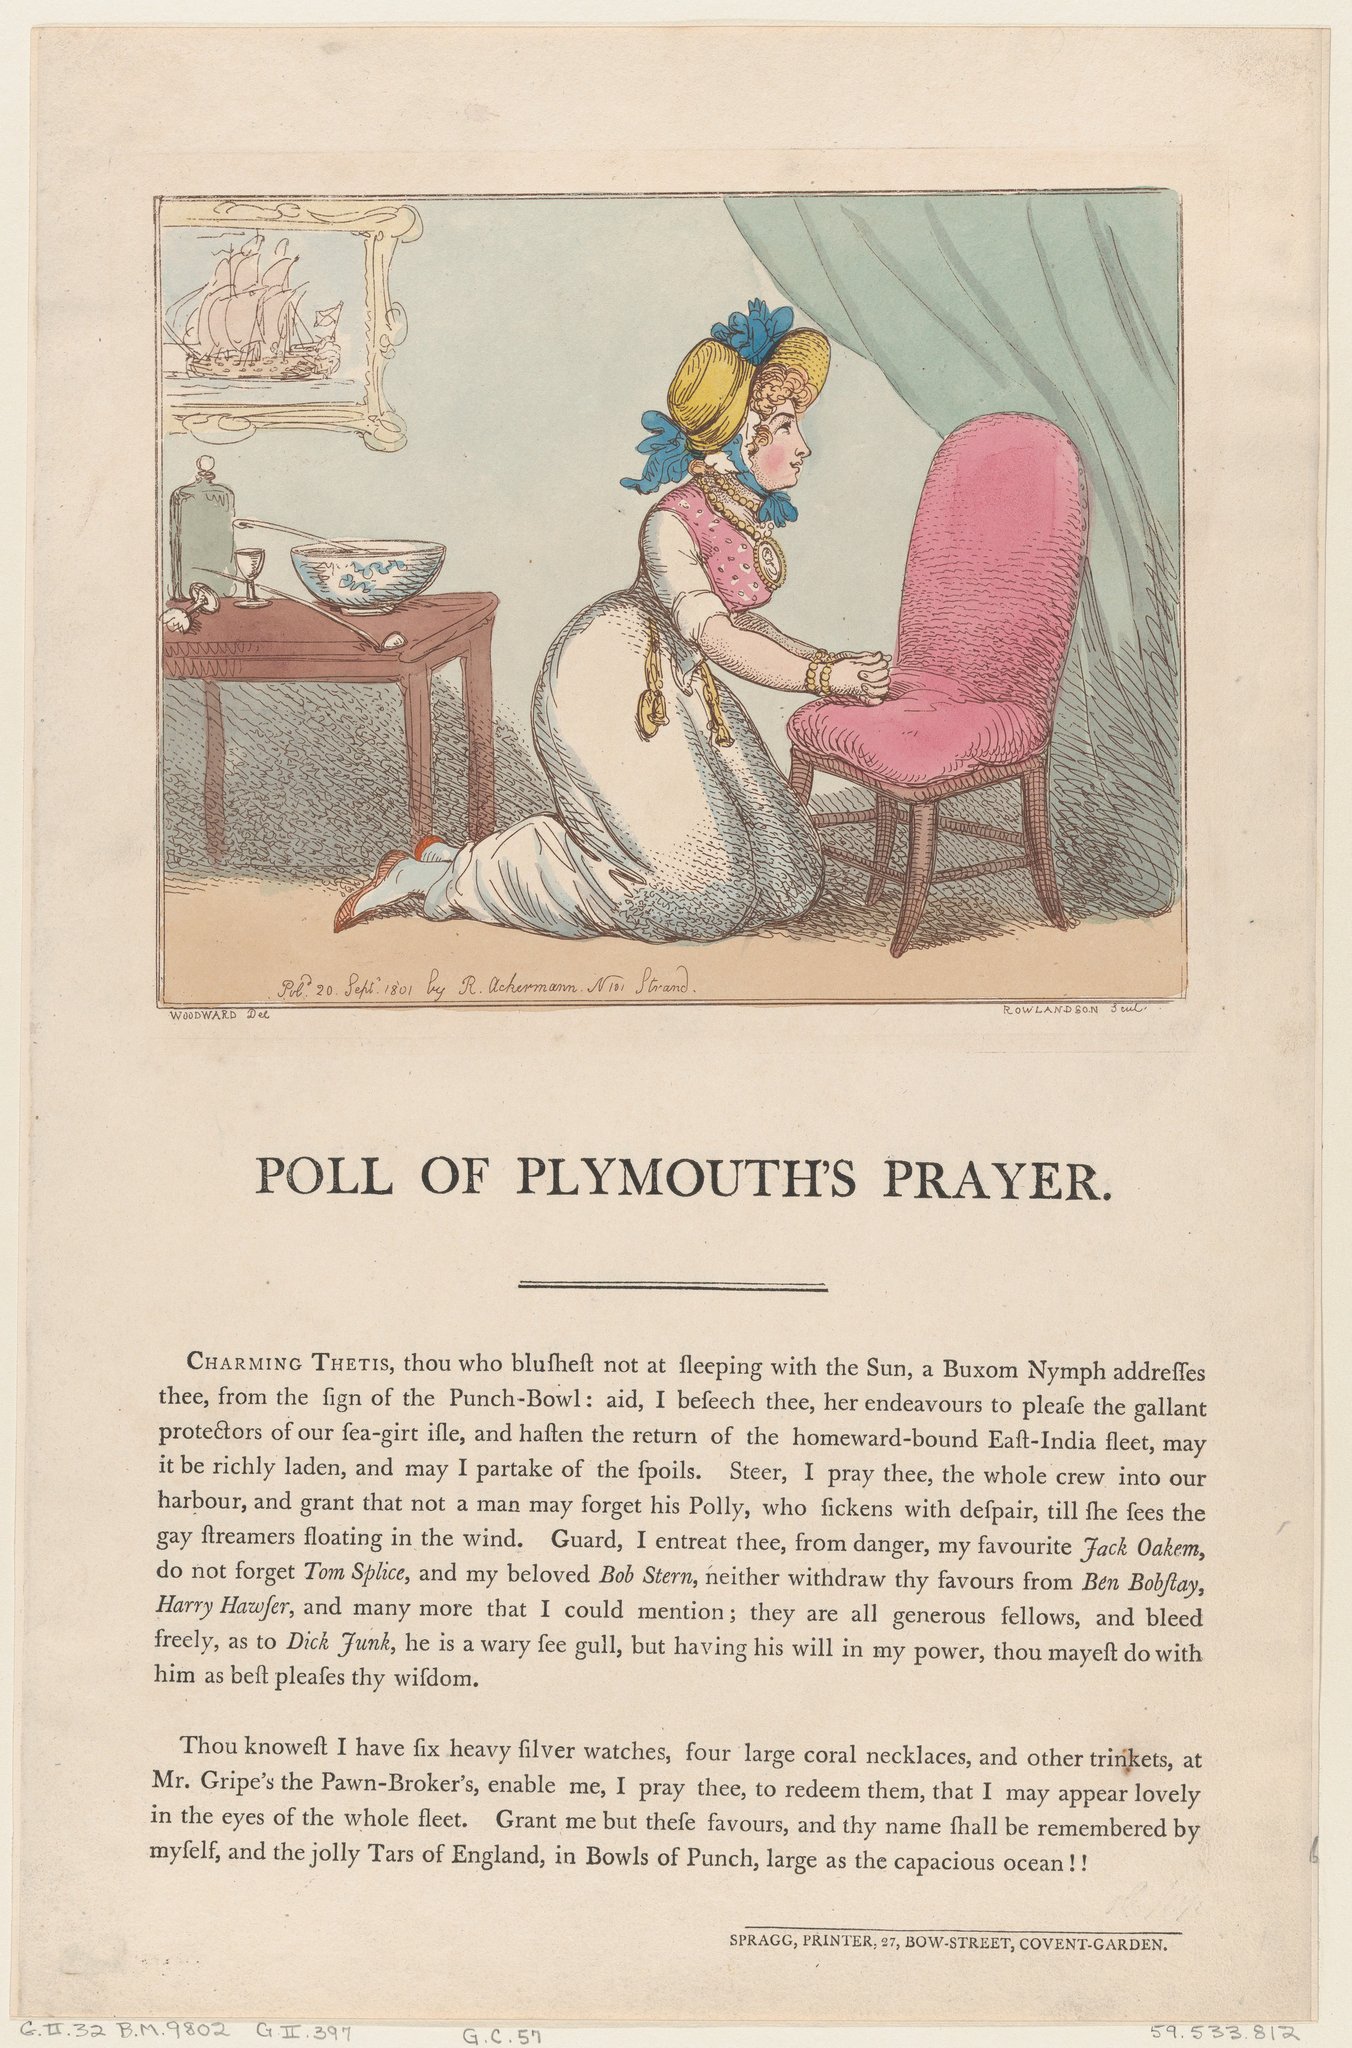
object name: print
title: Poll of Plymouth's Prayer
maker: thomas rowlandson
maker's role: artist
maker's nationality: british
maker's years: 1757-1827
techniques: etching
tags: women,chairs